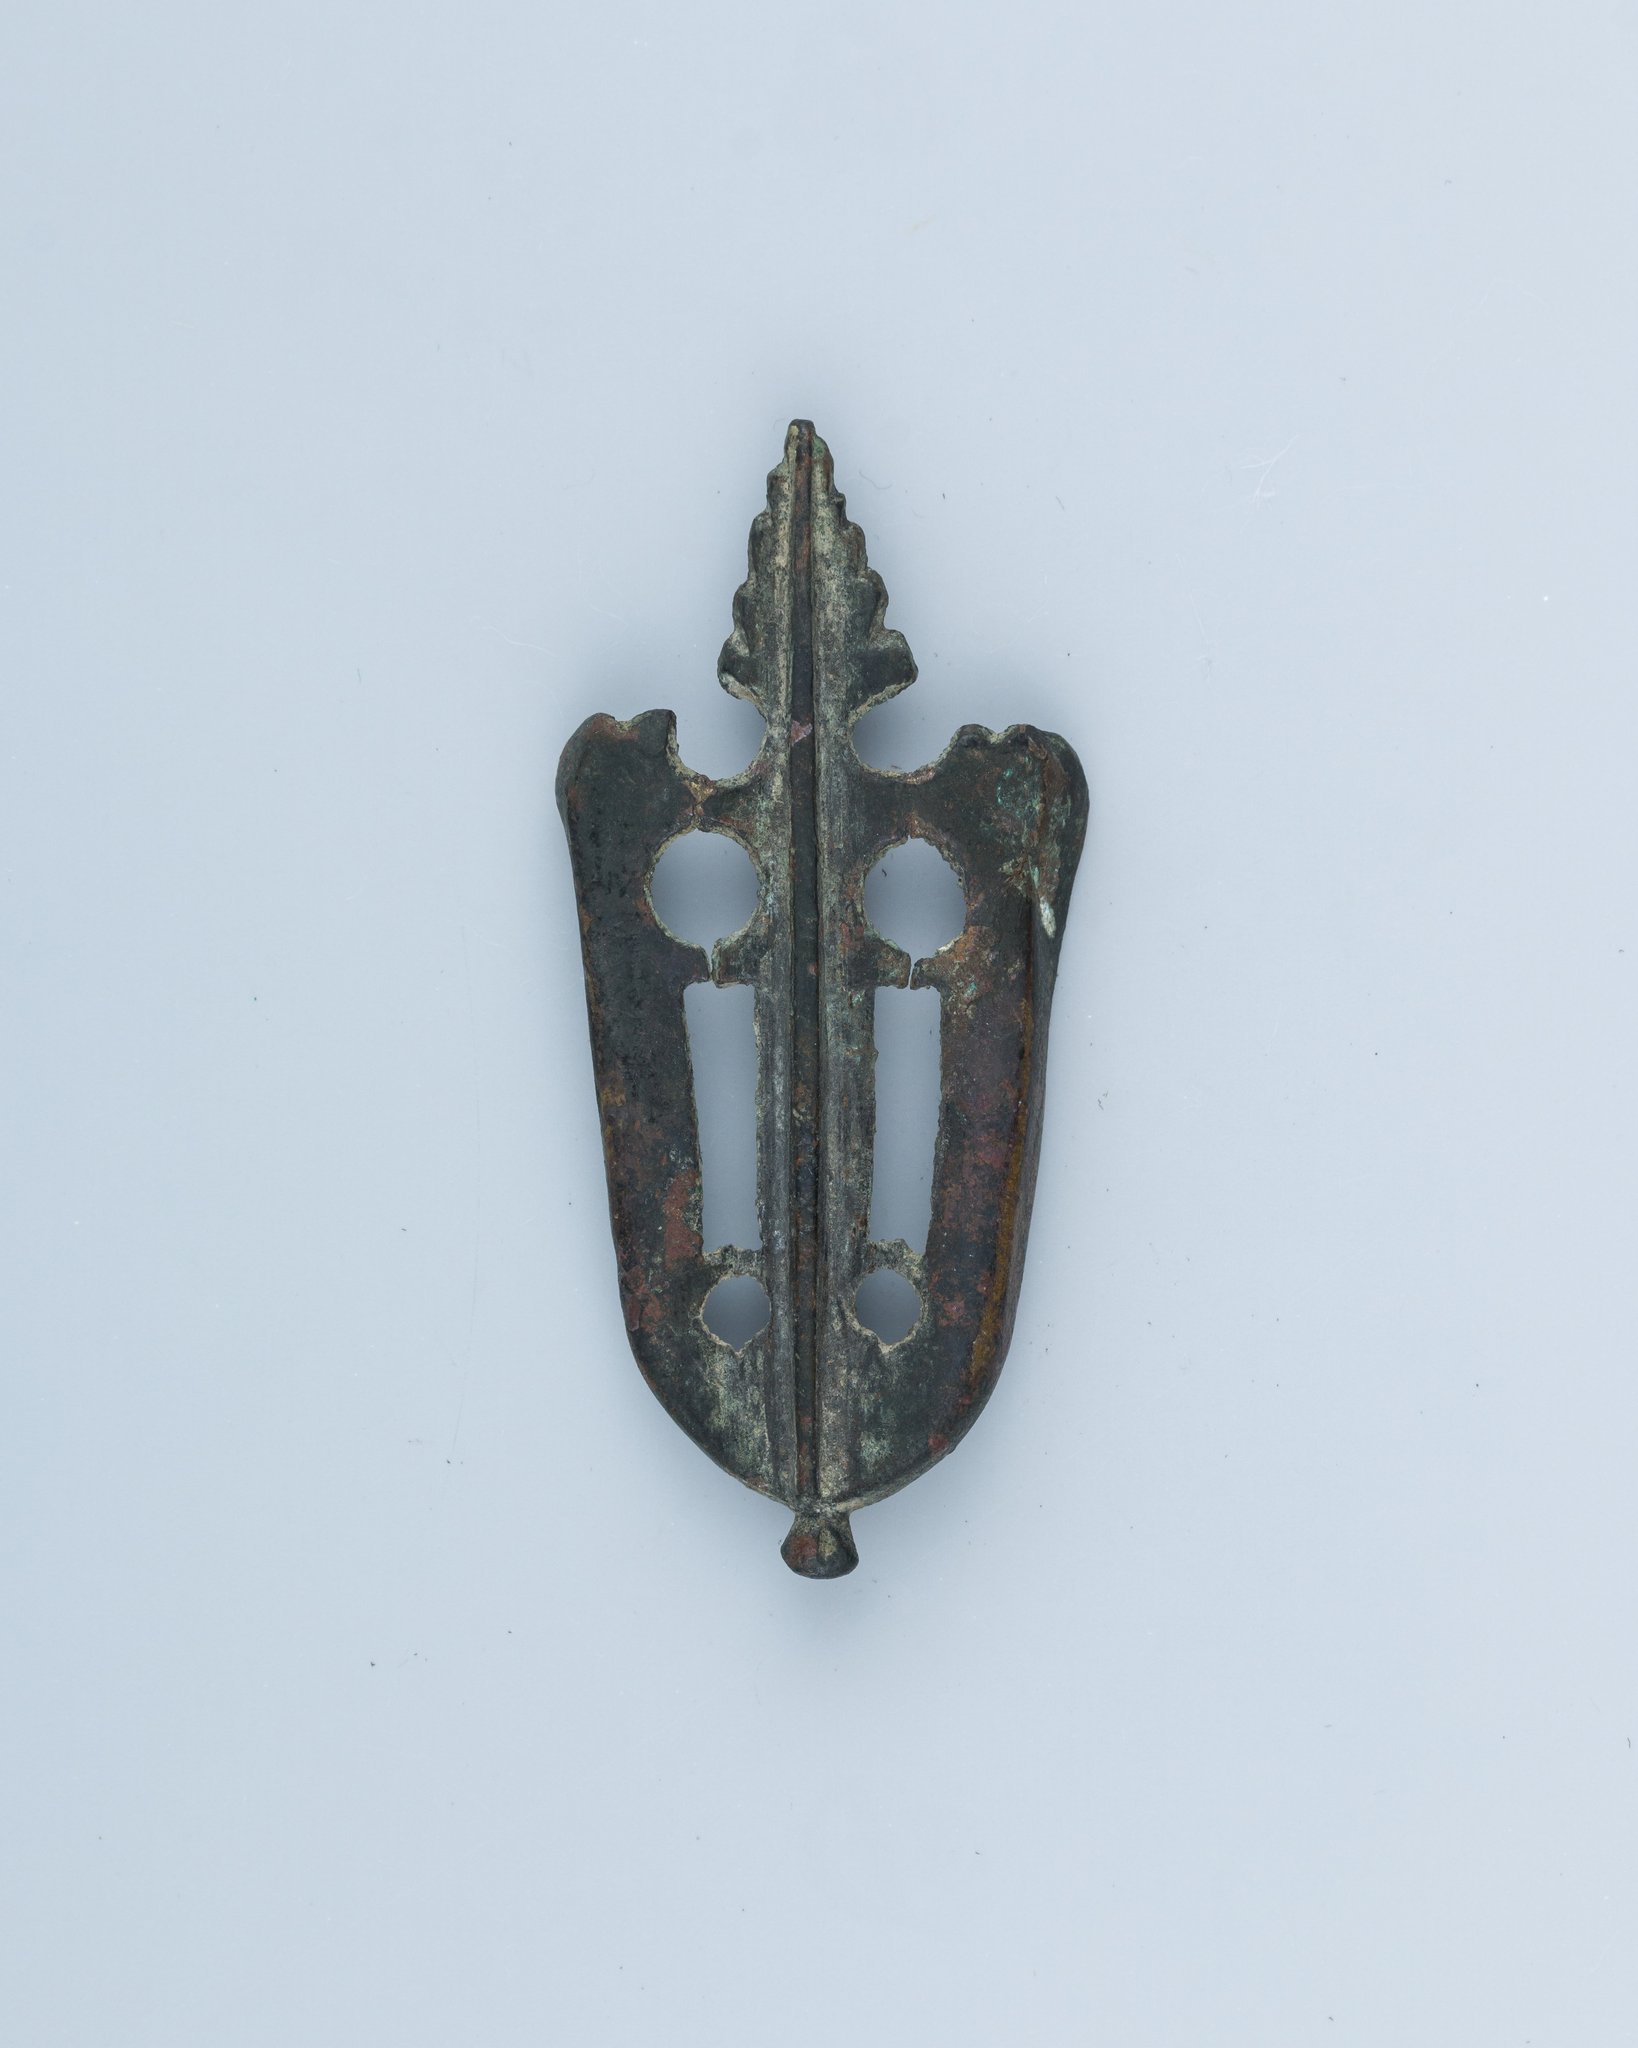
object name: pendant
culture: european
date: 1401-1700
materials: bronze